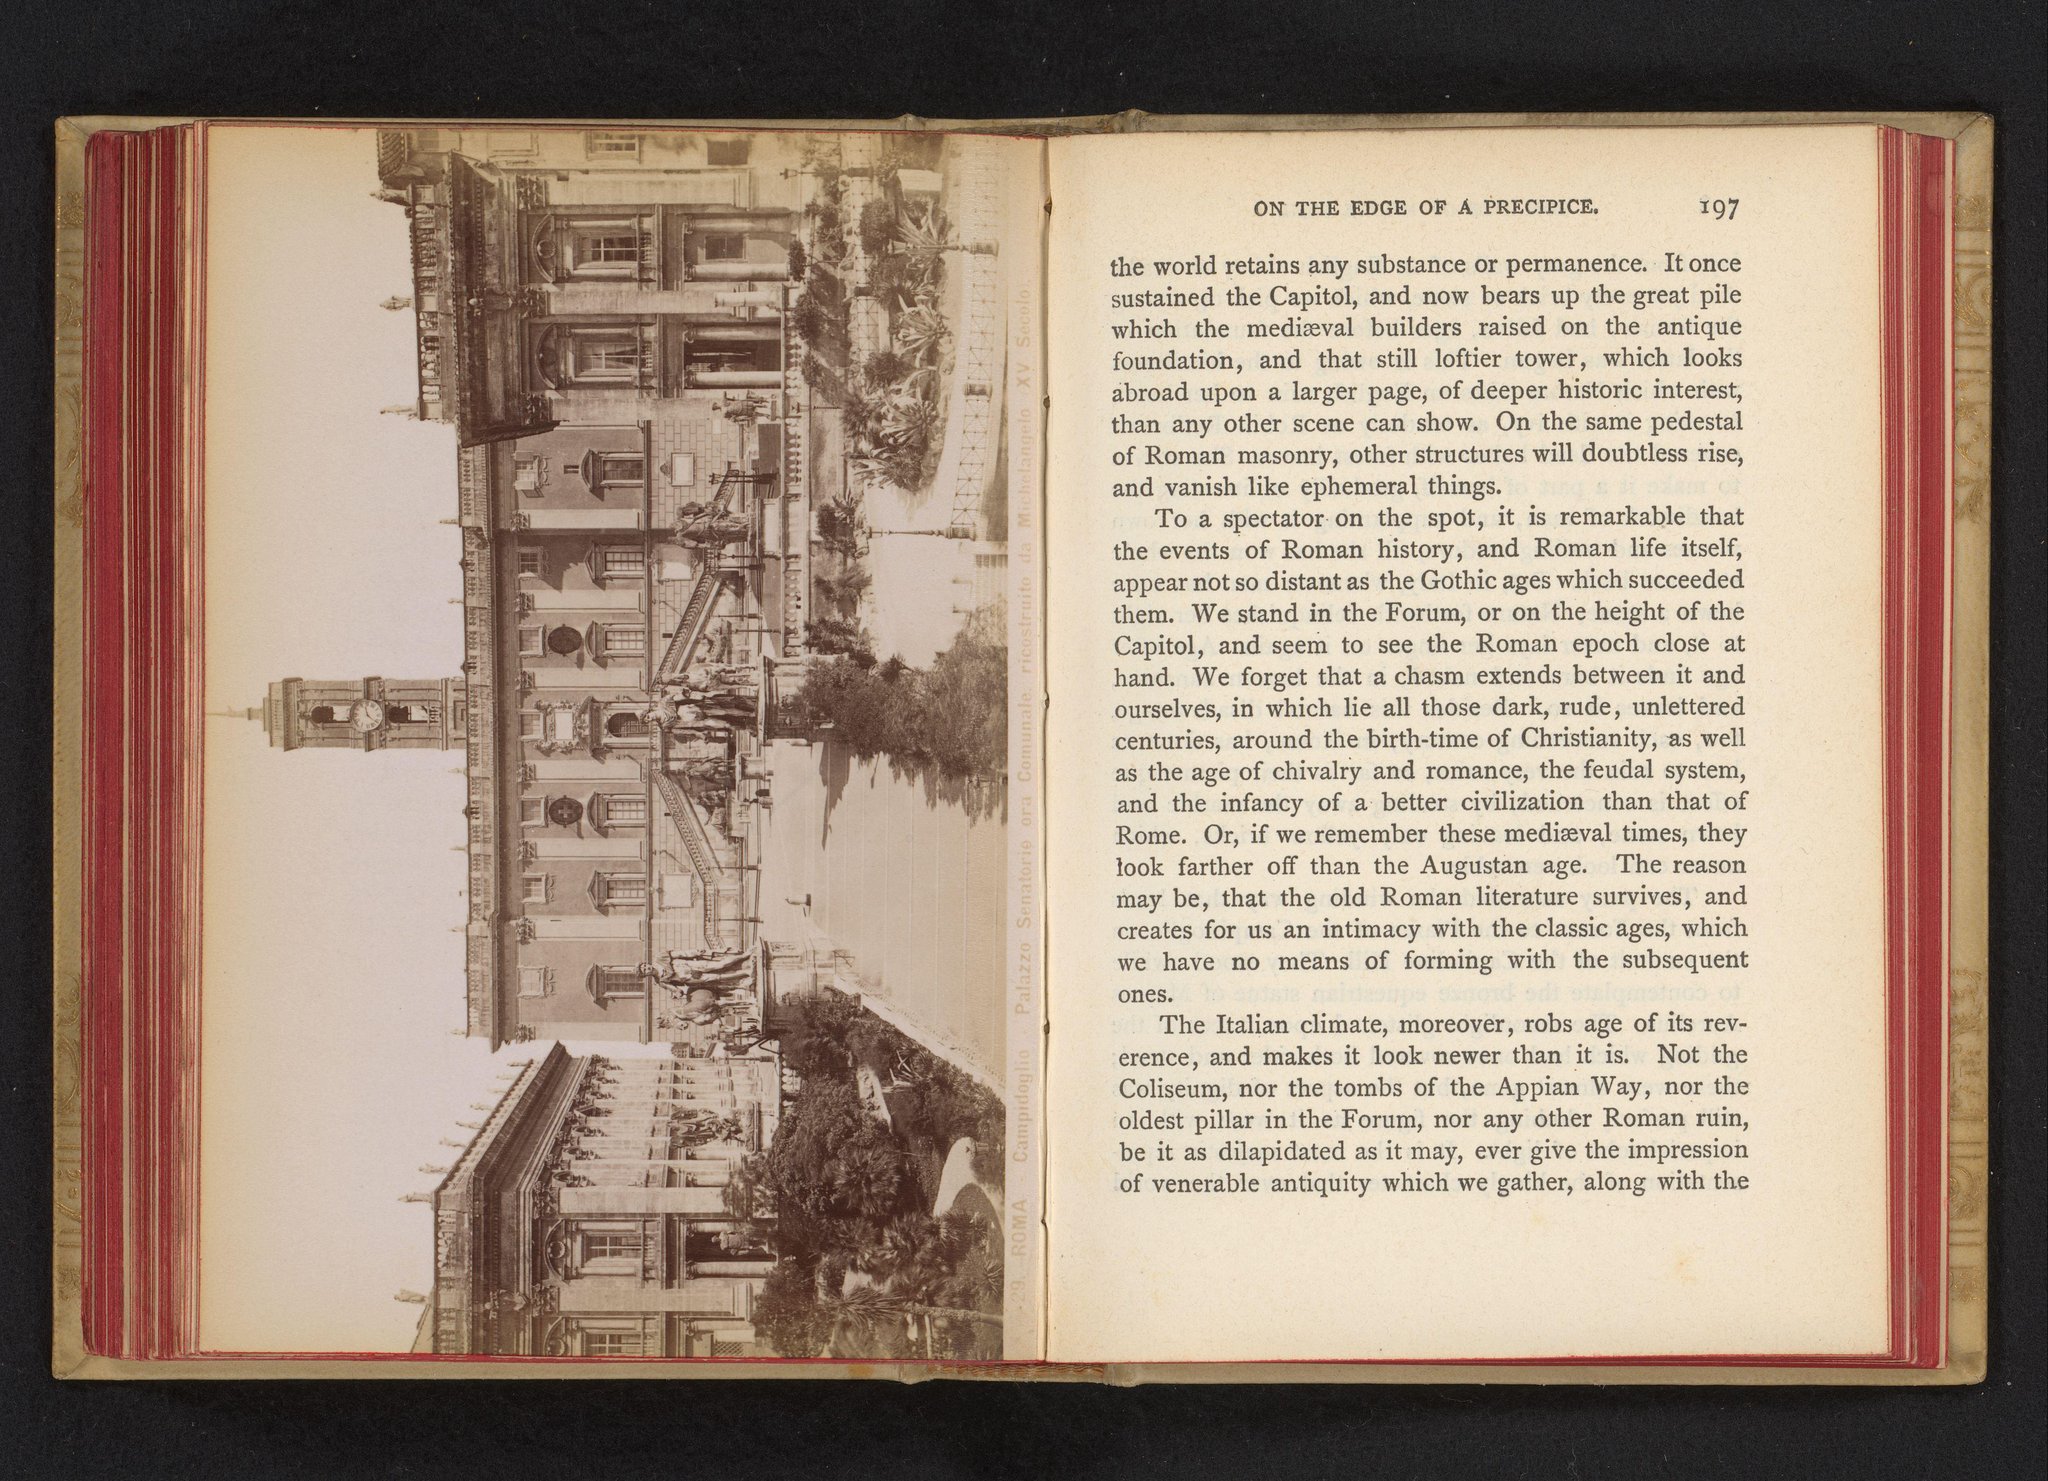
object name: photograph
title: Palazzo Senatorio aan het Piazza del Campidoglio in Rome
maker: Anonymous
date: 1855-1860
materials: paper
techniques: albumen print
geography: rome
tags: townhall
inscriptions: number: ‘29.’